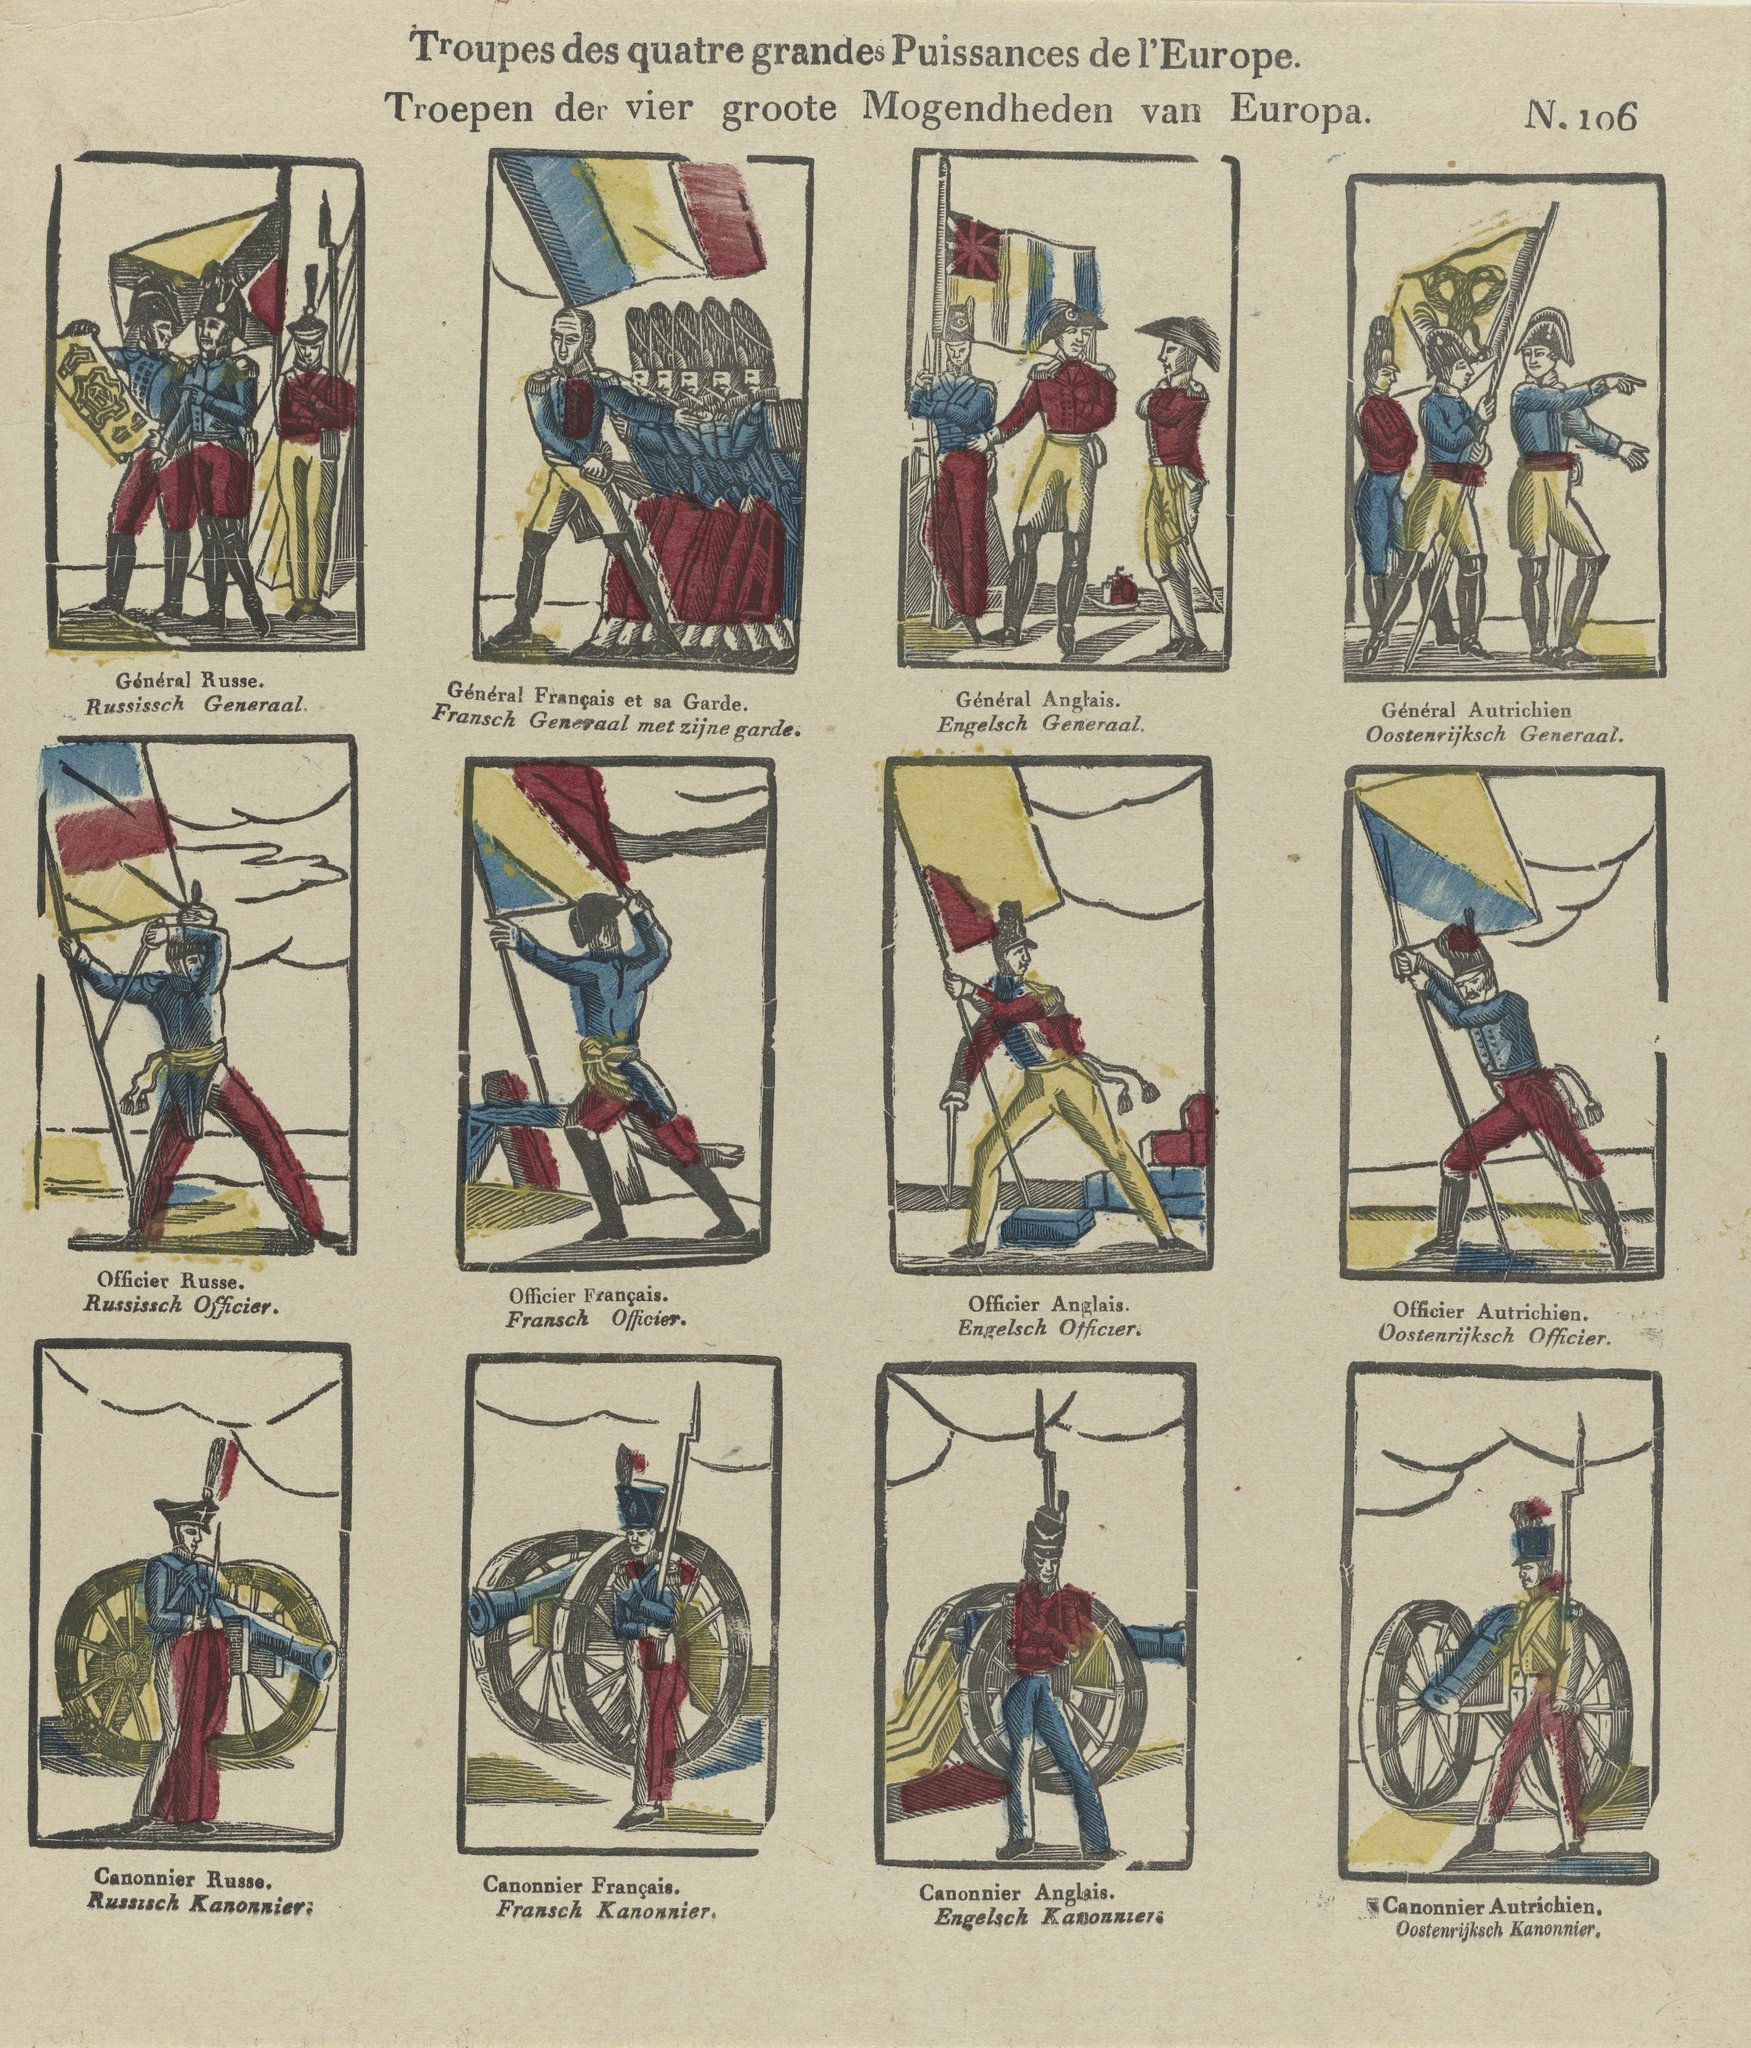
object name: popular print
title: Troupes des quatre grandes Puissances de l'Europe / troepen der vier groote mogendheden van Europa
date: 1800-1833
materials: paper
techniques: colour, letterpress printing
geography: turnhout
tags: the soldier; the soldier's life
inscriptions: collector's mark: Lugt 2760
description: Blad met 12 voorstellingen van soldaten en generaals van de vier grote Europese mogendheden, Frankrijk, Rusland, Engeland en Oostenrijk. Onder elke voorstelling een onderschrift in het Frans en in het Nederlands. Genummerd rechtsboven: N. 106.